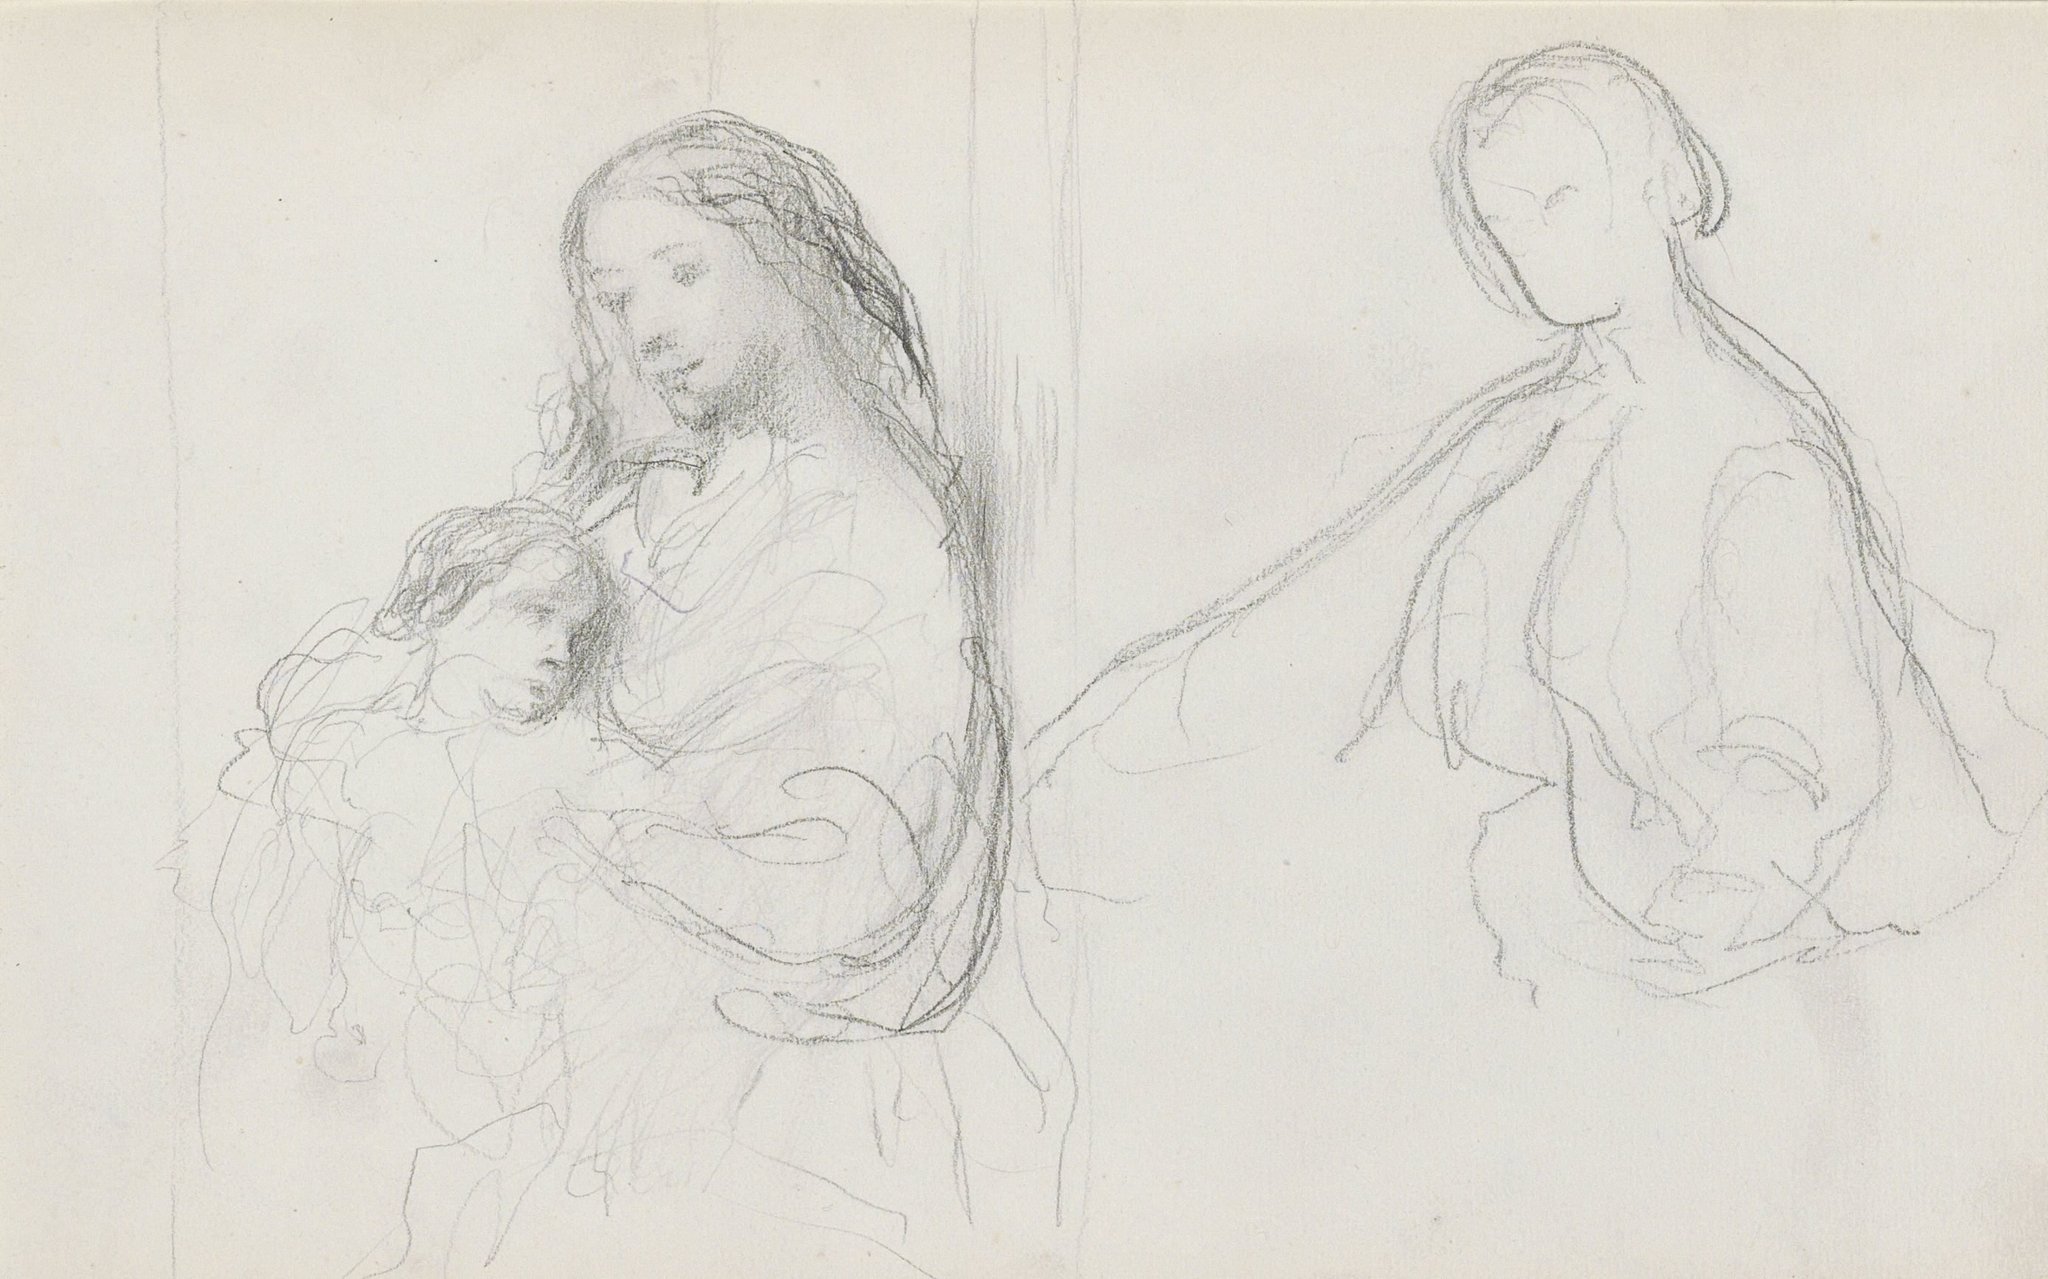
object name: sketchbook leaf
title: Moeder met kind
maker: bastiaan de poorter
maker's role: painter, print maker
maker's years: 1813-1880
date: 1858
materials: paper, pencil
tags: mother and baby or young child, arm stretched sidewards - aa - both arms or hands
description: Tevens een studie van een vrouw met opengespreide armen. Blad 21 recto uit een gecombineerd album amicorum en schetsboek met in totaal 39 bladen.